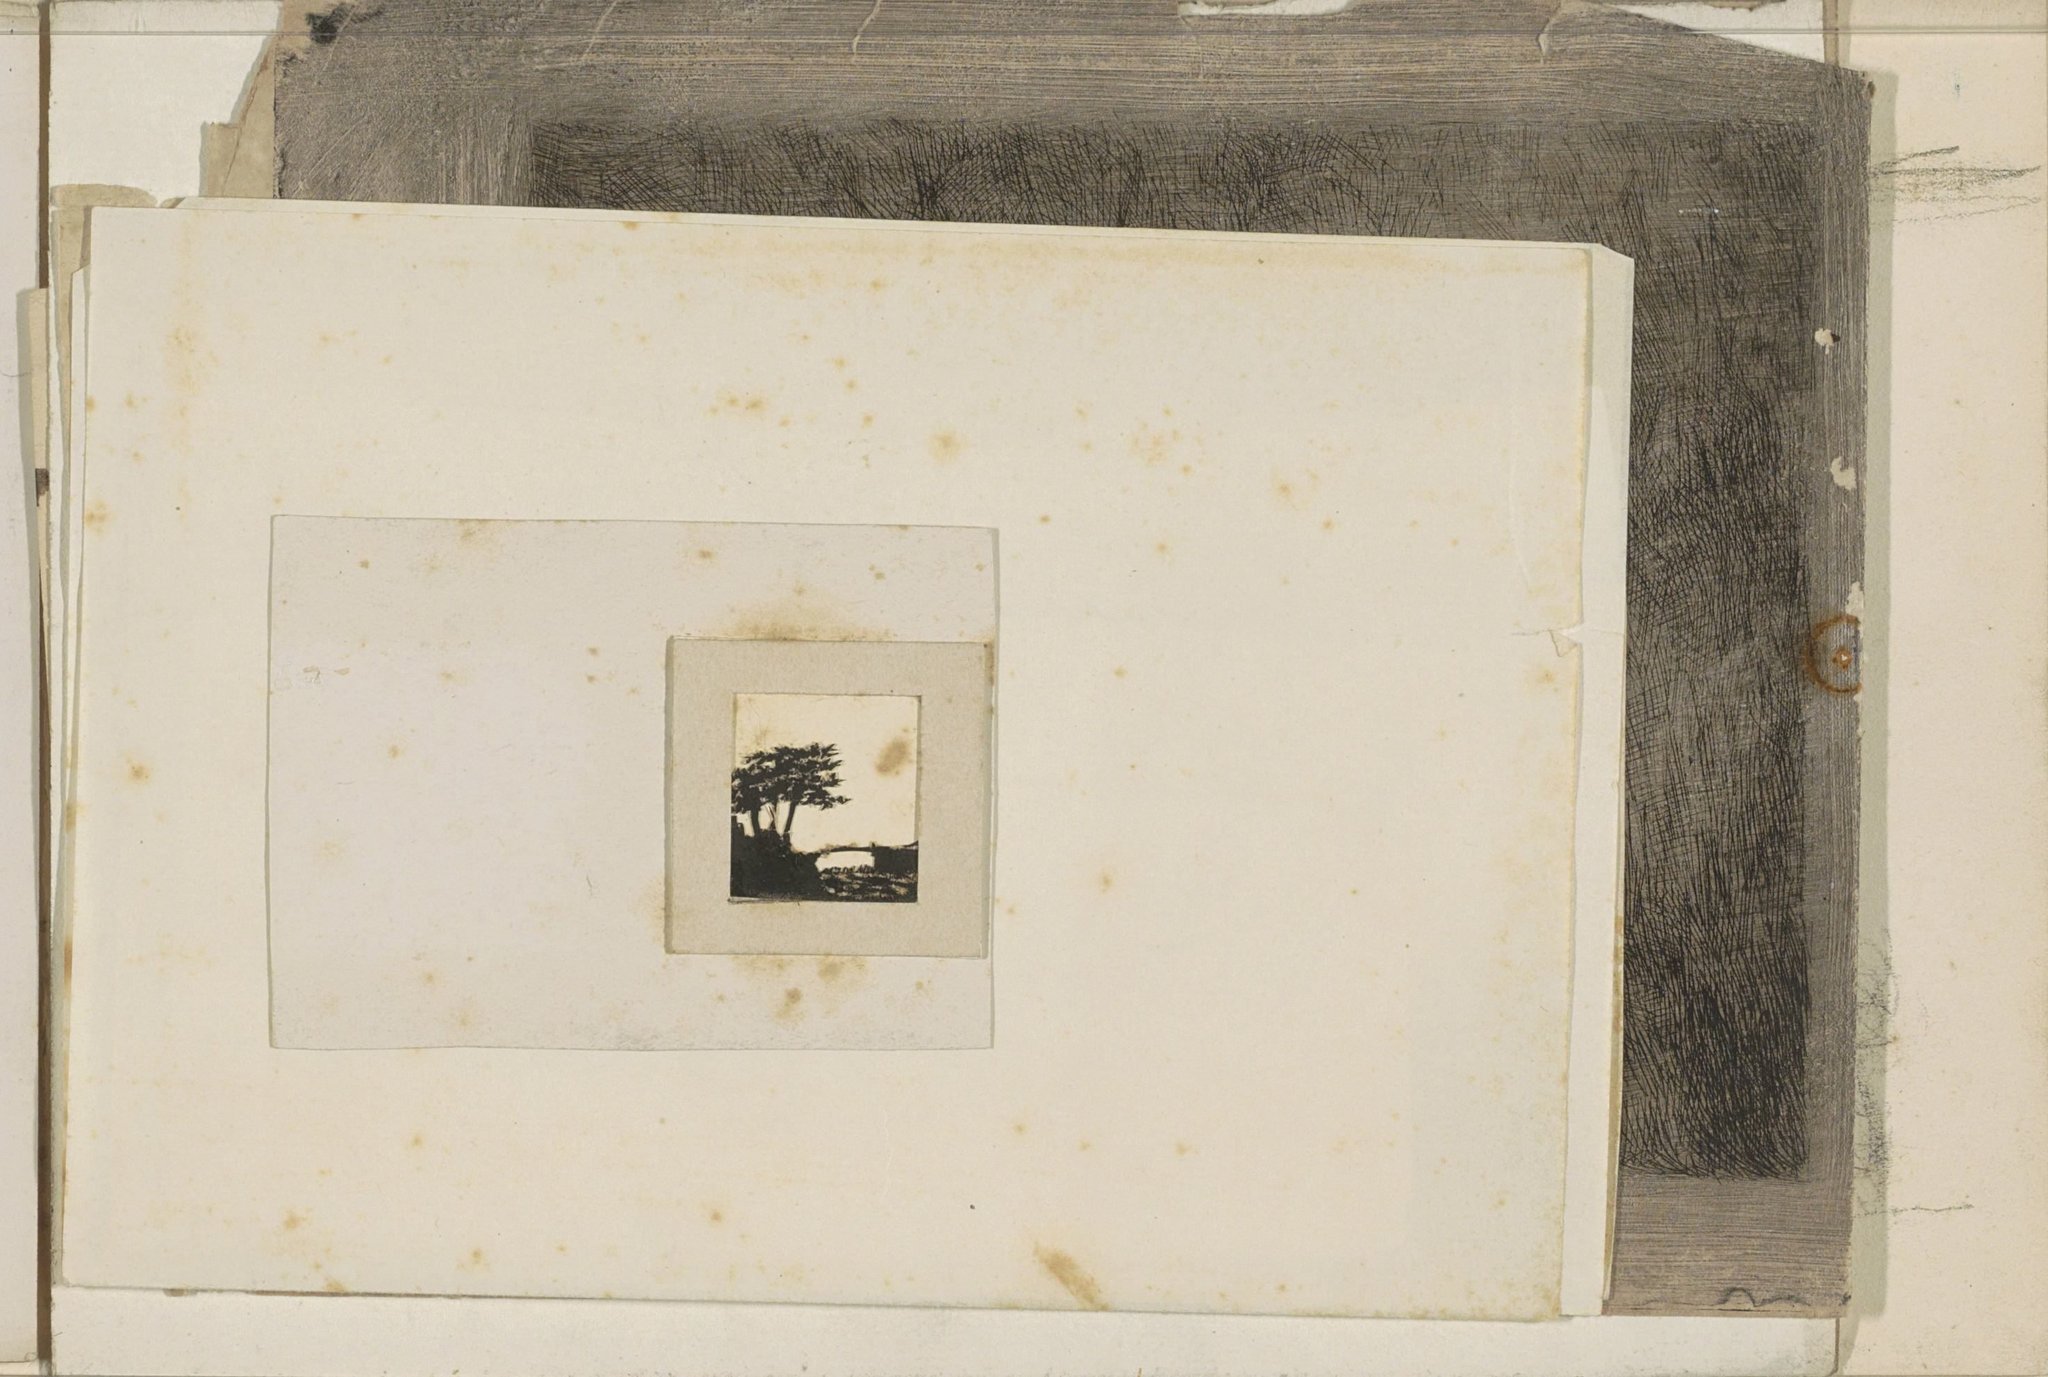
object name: sketchbook leaf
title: Landschap met een brug en een boom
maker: a.a.l. de grammont-hubrecht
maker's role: draughtsman, painter, print maker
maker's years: 1855-1913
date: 1865-1913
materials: paper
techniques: cutting, scoring, snipping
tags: trees, landscapes with waters, waterscapes, seascapes (in the temperate zone), bridge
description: Los papierknipkunstwerk tussen pagina 1 en 2 uit een schetsboek met 68 bladen.